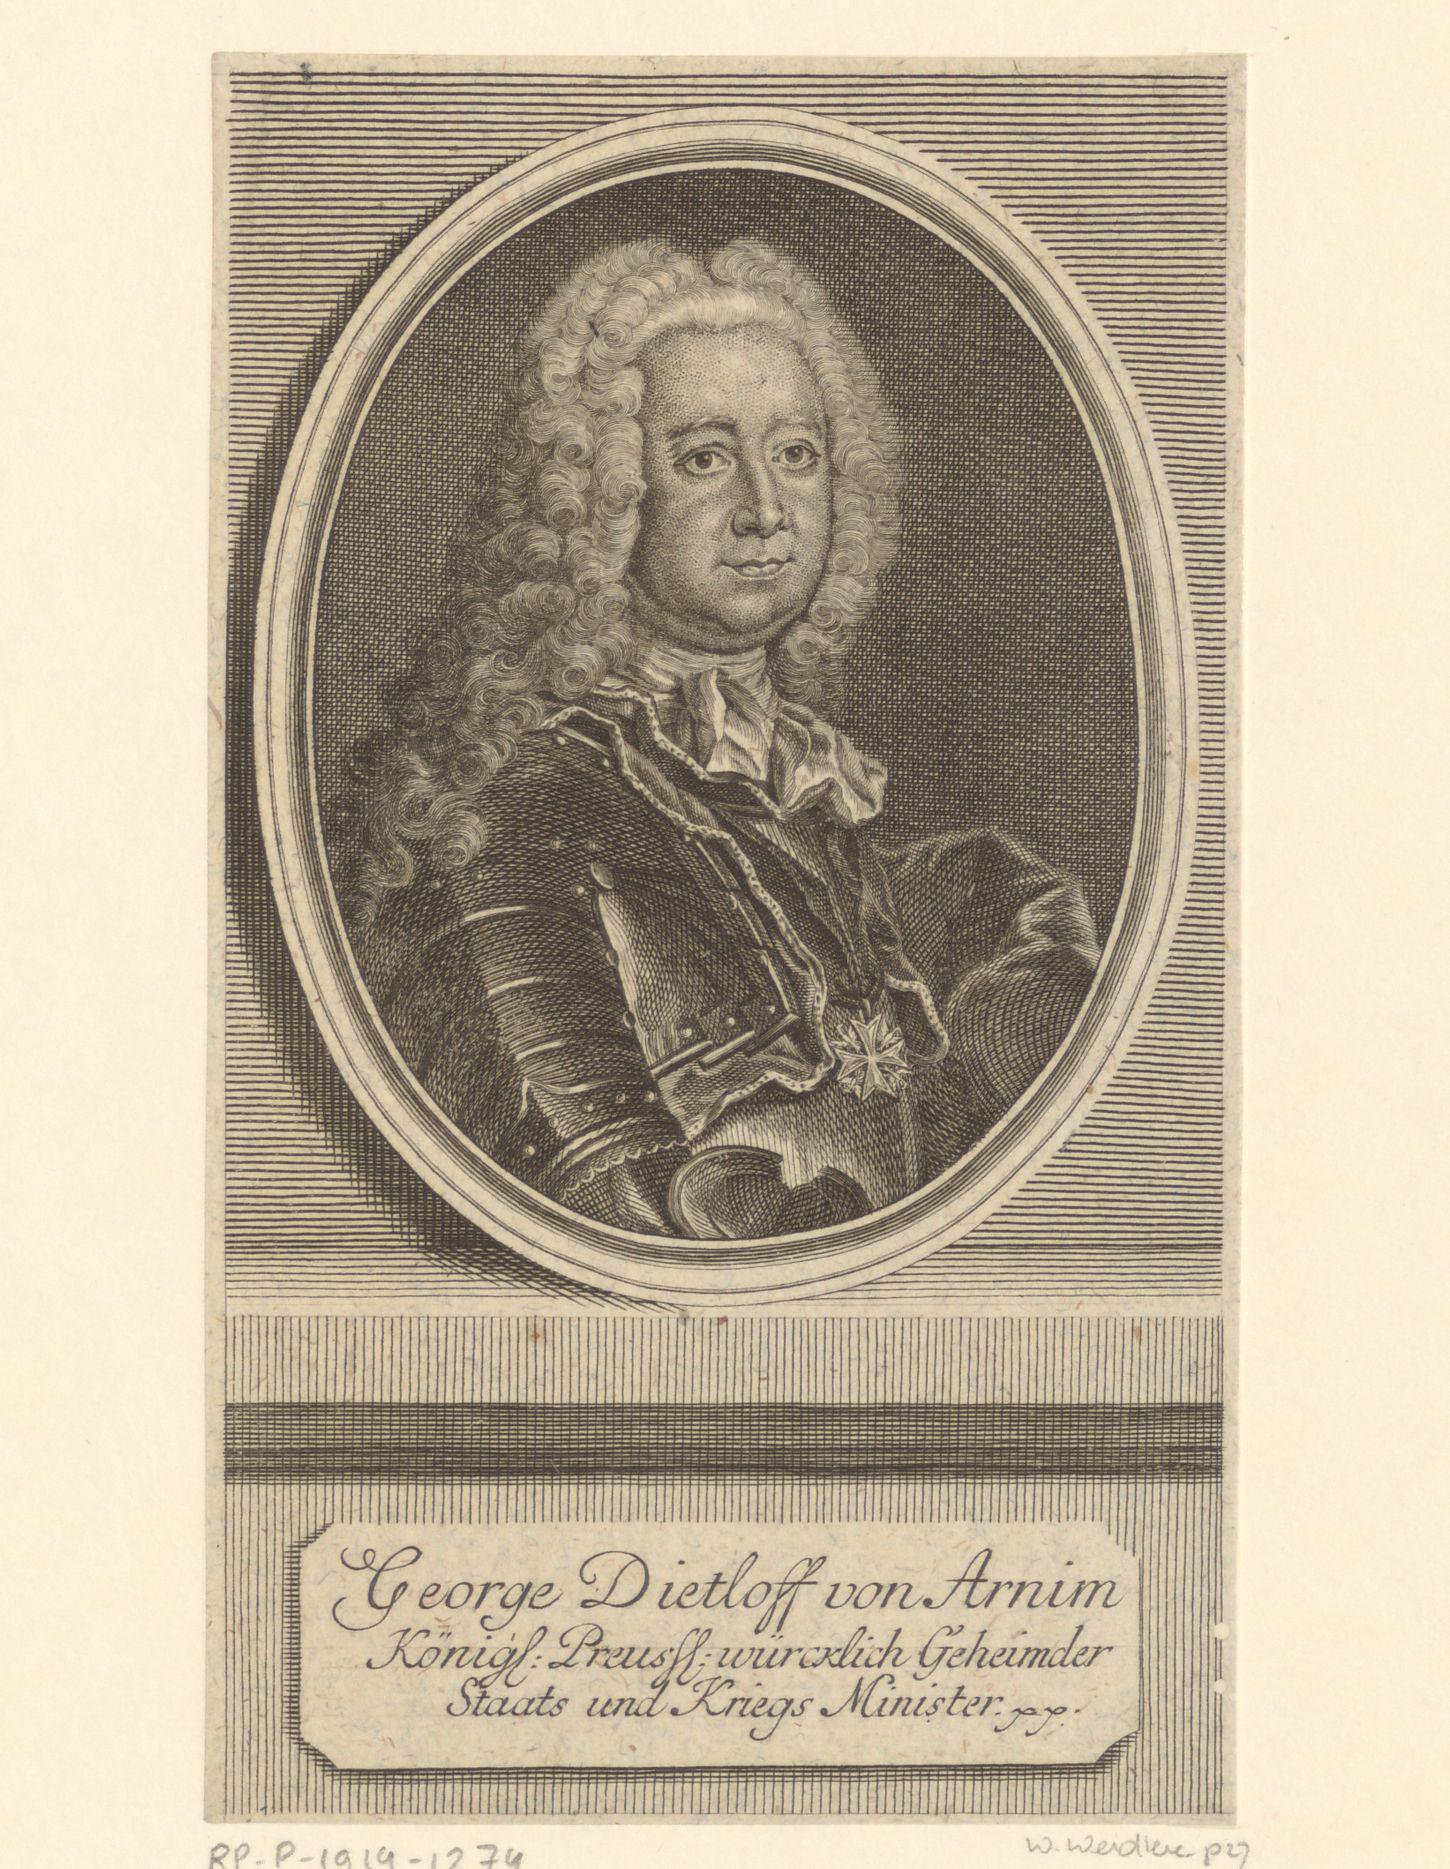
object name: print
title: Portret van Georg Dietloff von Arnim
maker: johann martin bernigeroth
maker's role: print maker, publisher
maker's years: 1713-1767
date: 1738-1767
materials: paper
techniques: engraving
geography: leipzig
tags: berlin, armour, historical persons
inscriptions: collector's mark: Lugt 2228